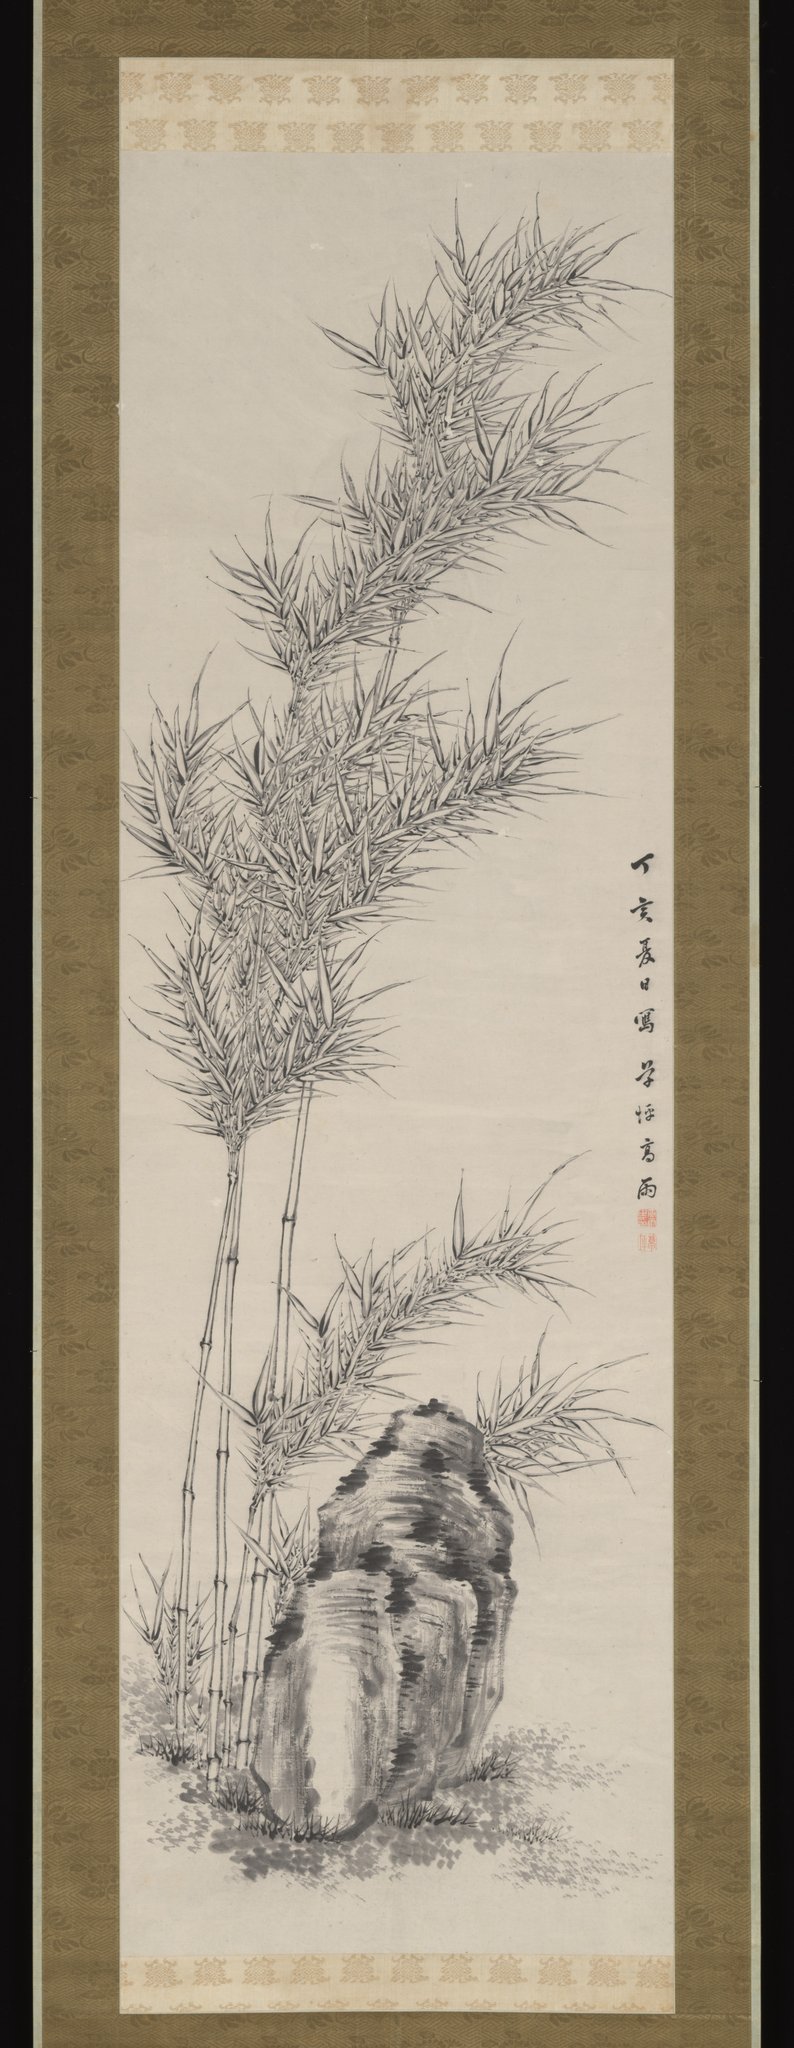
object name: hanging scroll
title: Bamboo in Summer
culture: japanese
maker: takahashi sōhei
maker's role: artist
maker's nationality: japanese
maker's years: 1804-1835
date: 1827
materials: ink, paper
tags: bamboo